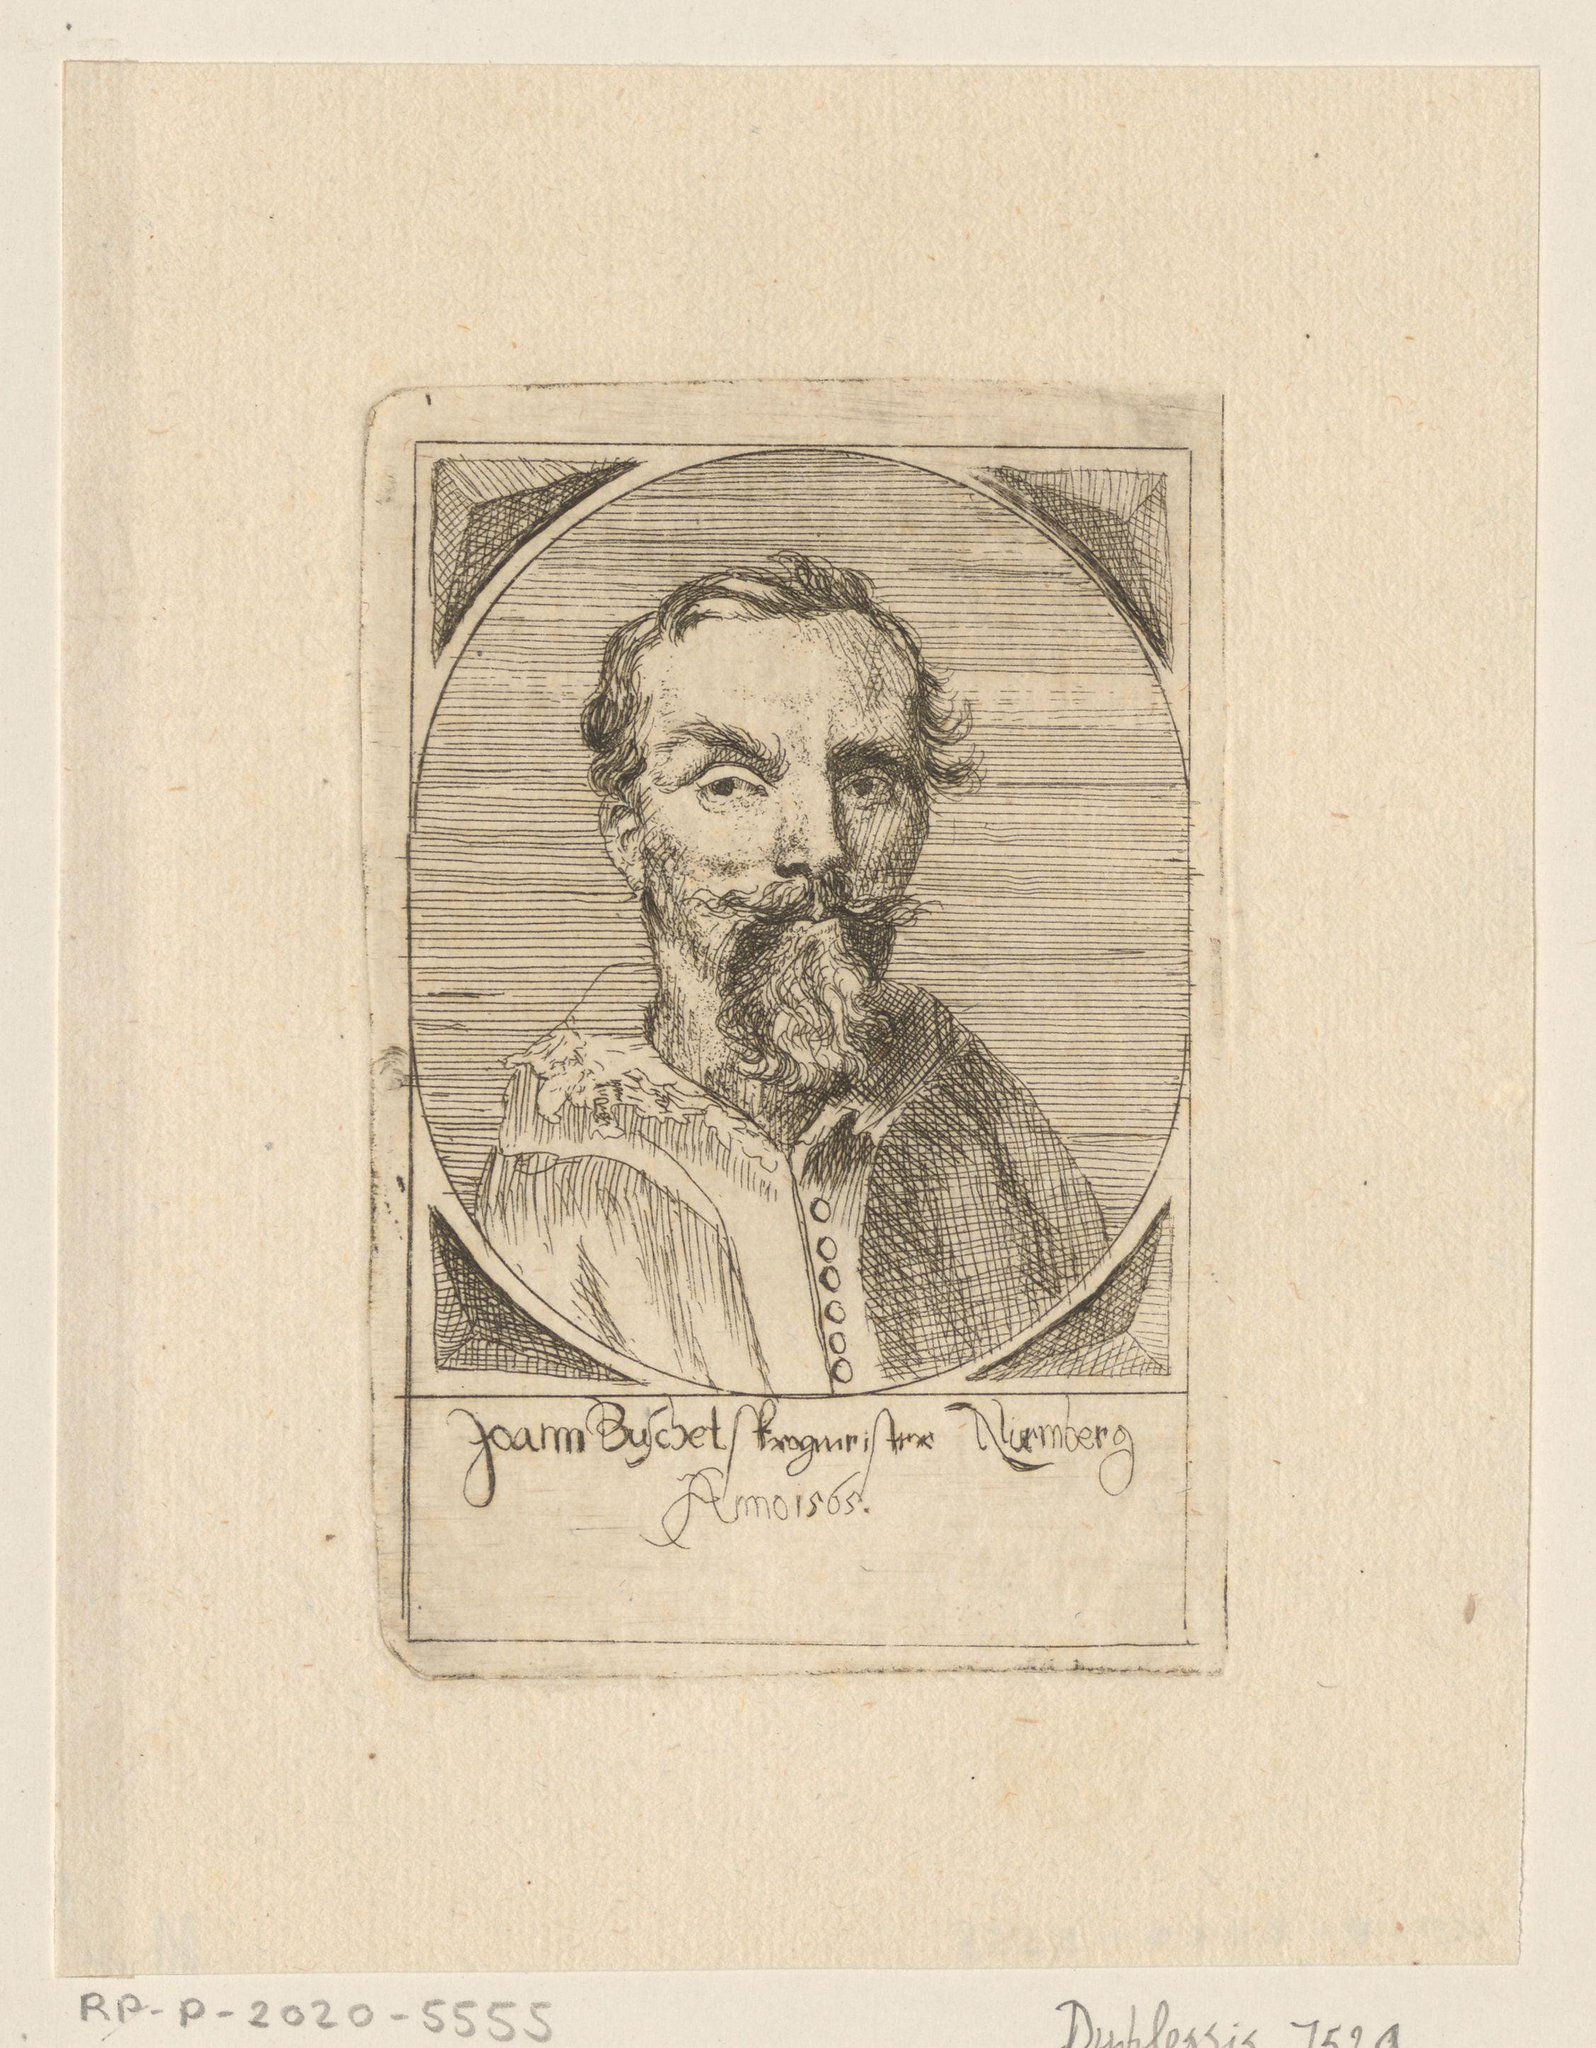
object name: print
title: Portret van Johann Buschet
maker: Anonymous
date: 1650-1749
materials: paper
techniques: etching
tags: historical persons